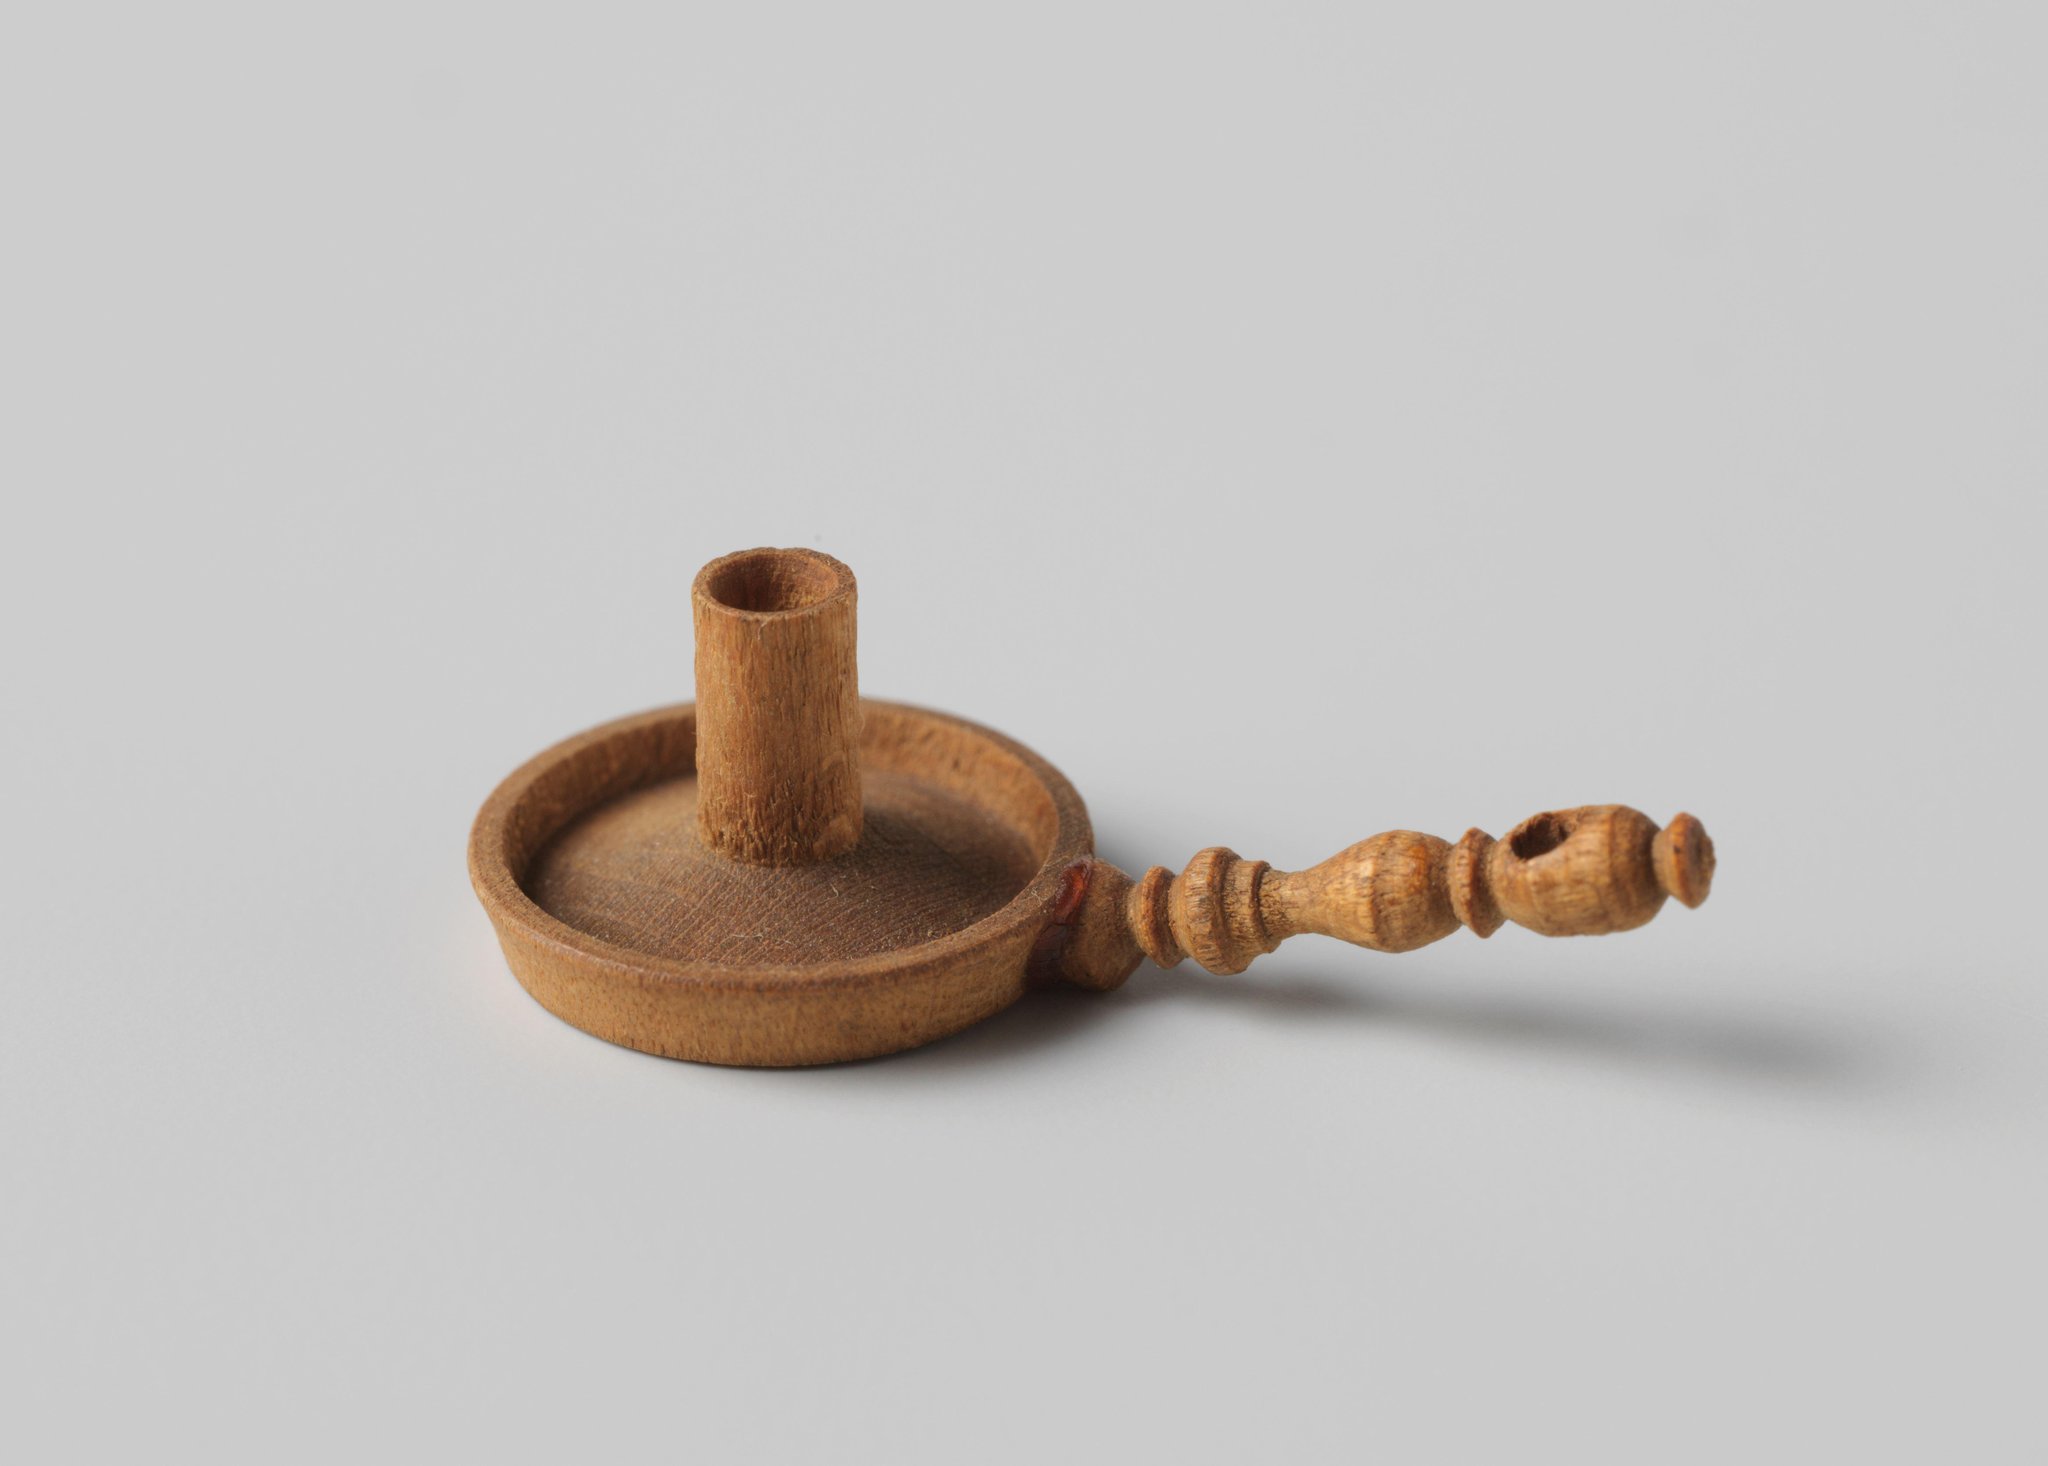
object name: lighting device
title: Blaker, gedraaid van hout, met geprofileerd handvat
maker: Anonymous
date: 1675-1700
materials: wood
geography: amsterdam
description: Blaker gedraaid van esdoornhout, met geprofileerd handvat met gat.